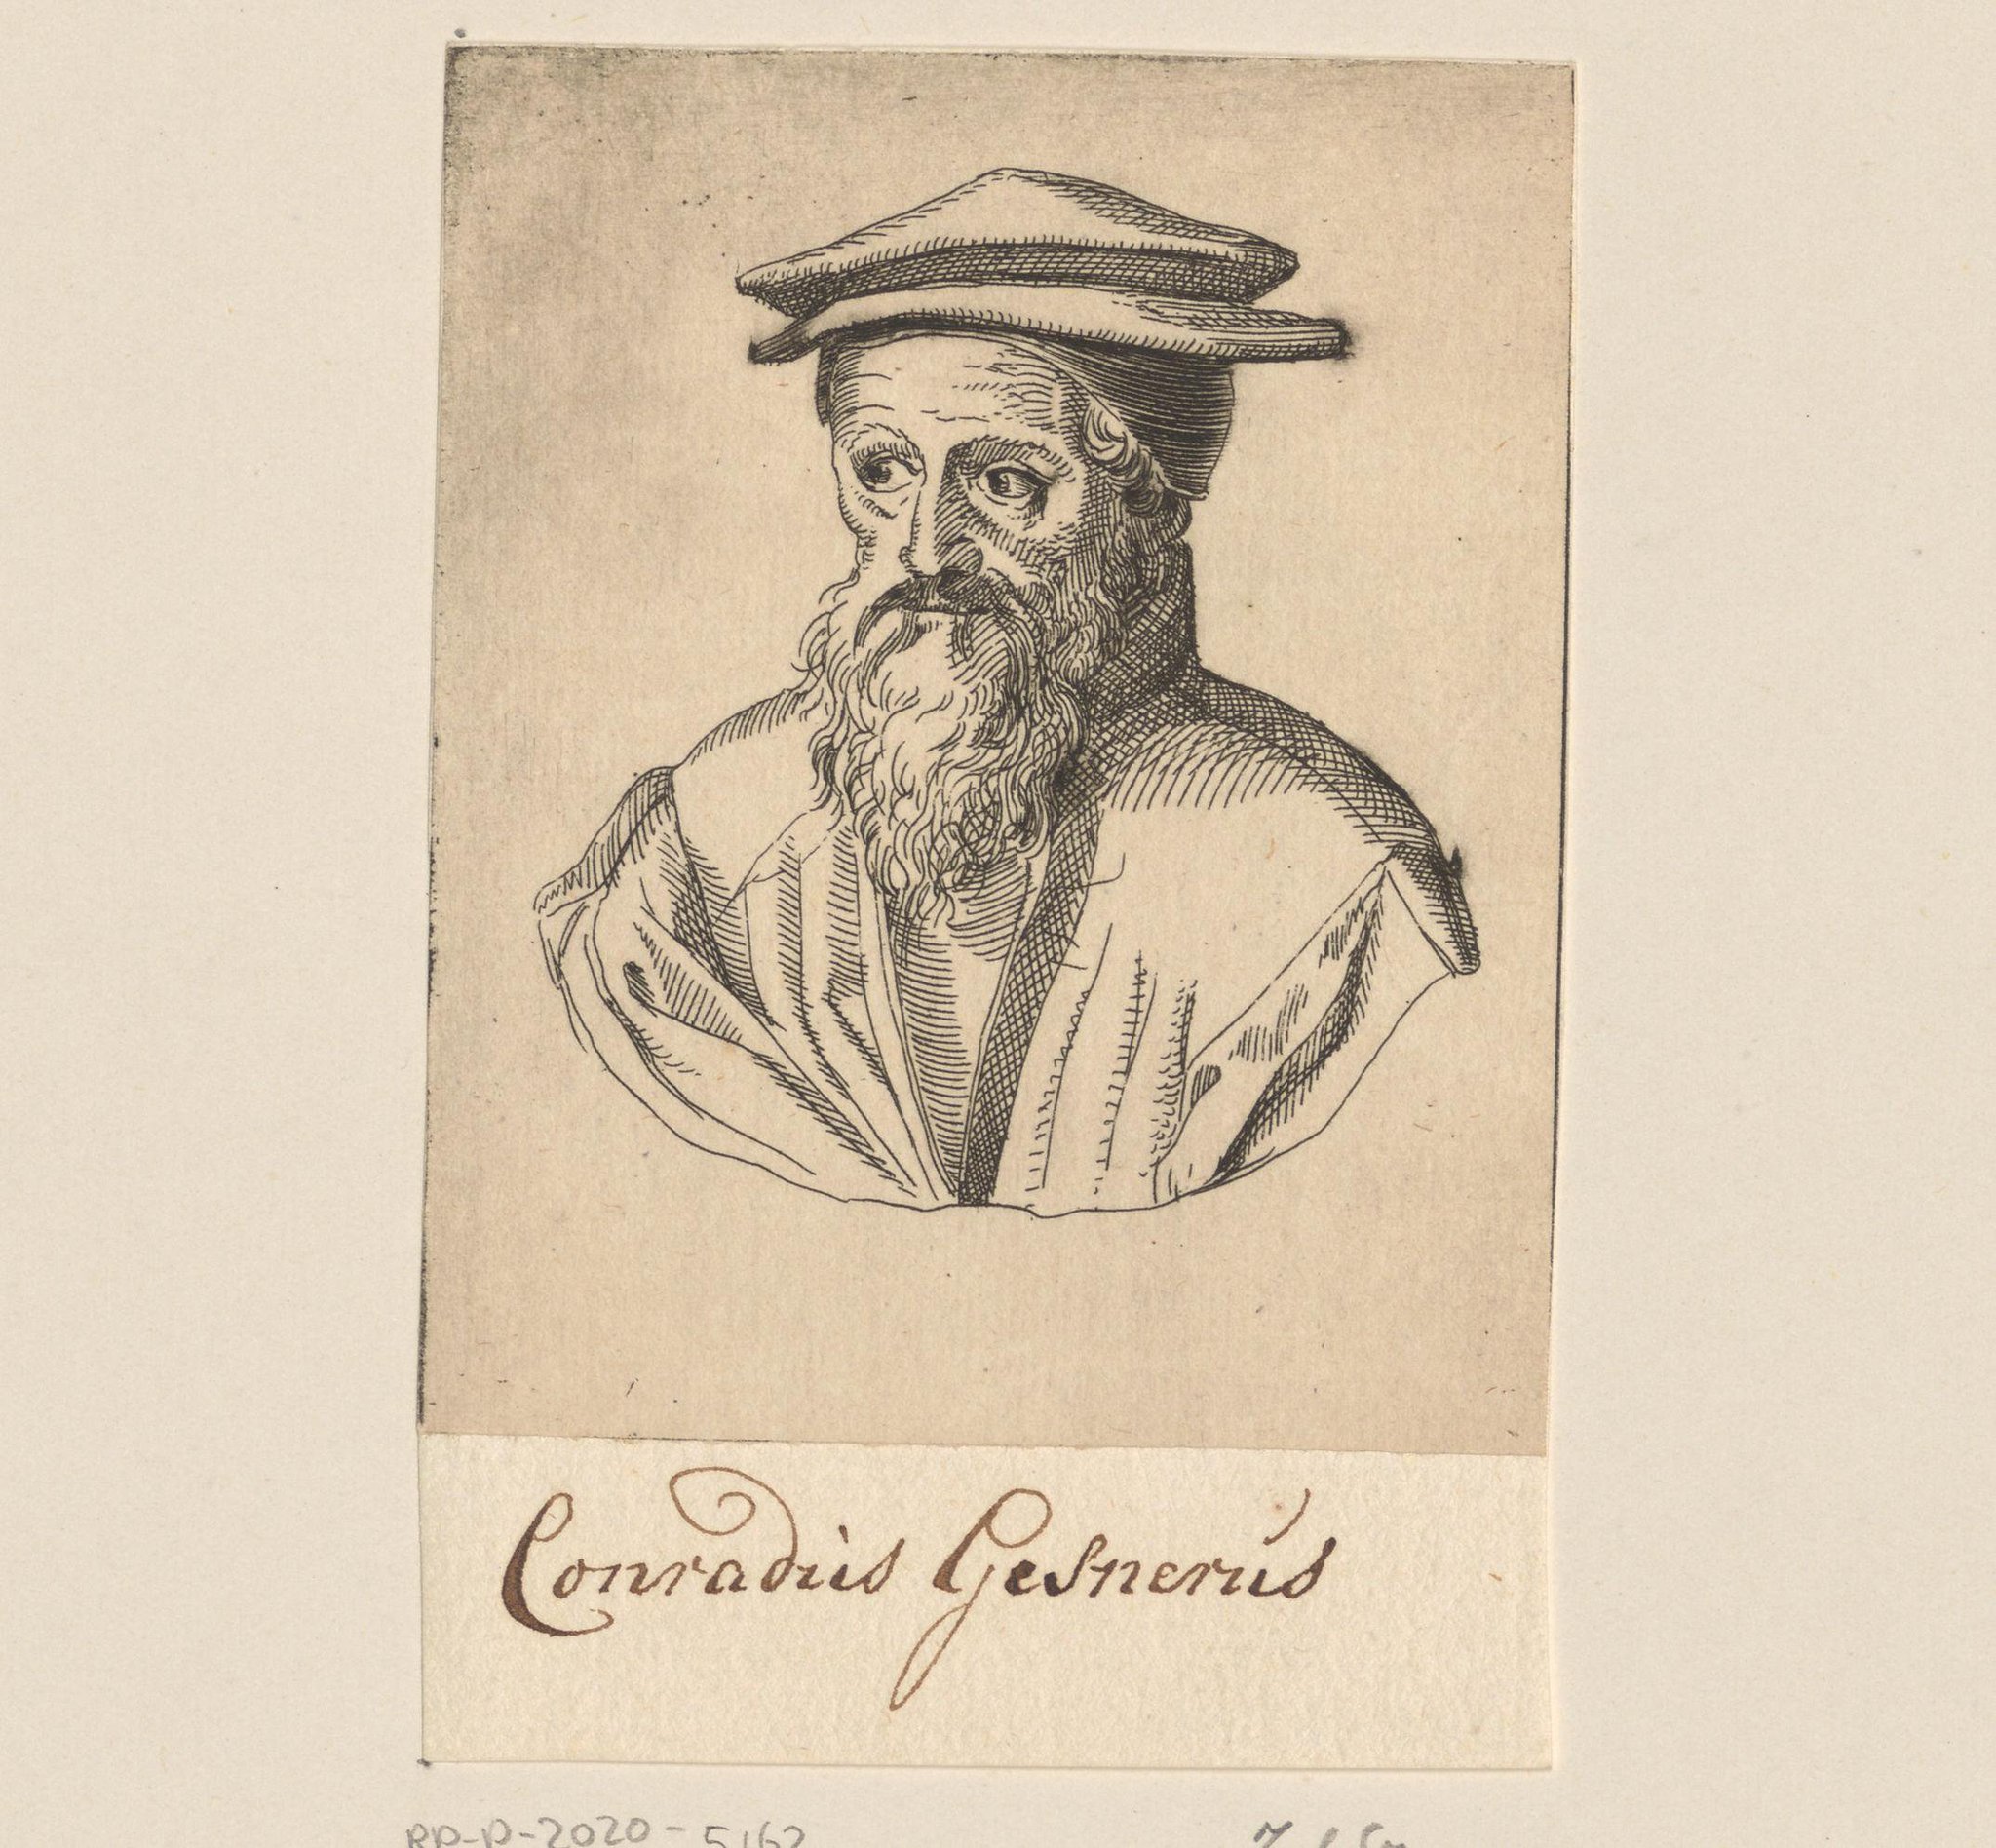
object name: print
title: Portret van Conrad Gesner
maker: Anonymous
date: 1600-1700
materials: paper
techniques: etching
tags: physicist, theologian, historical persons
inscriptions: : ‘zeldzaam’